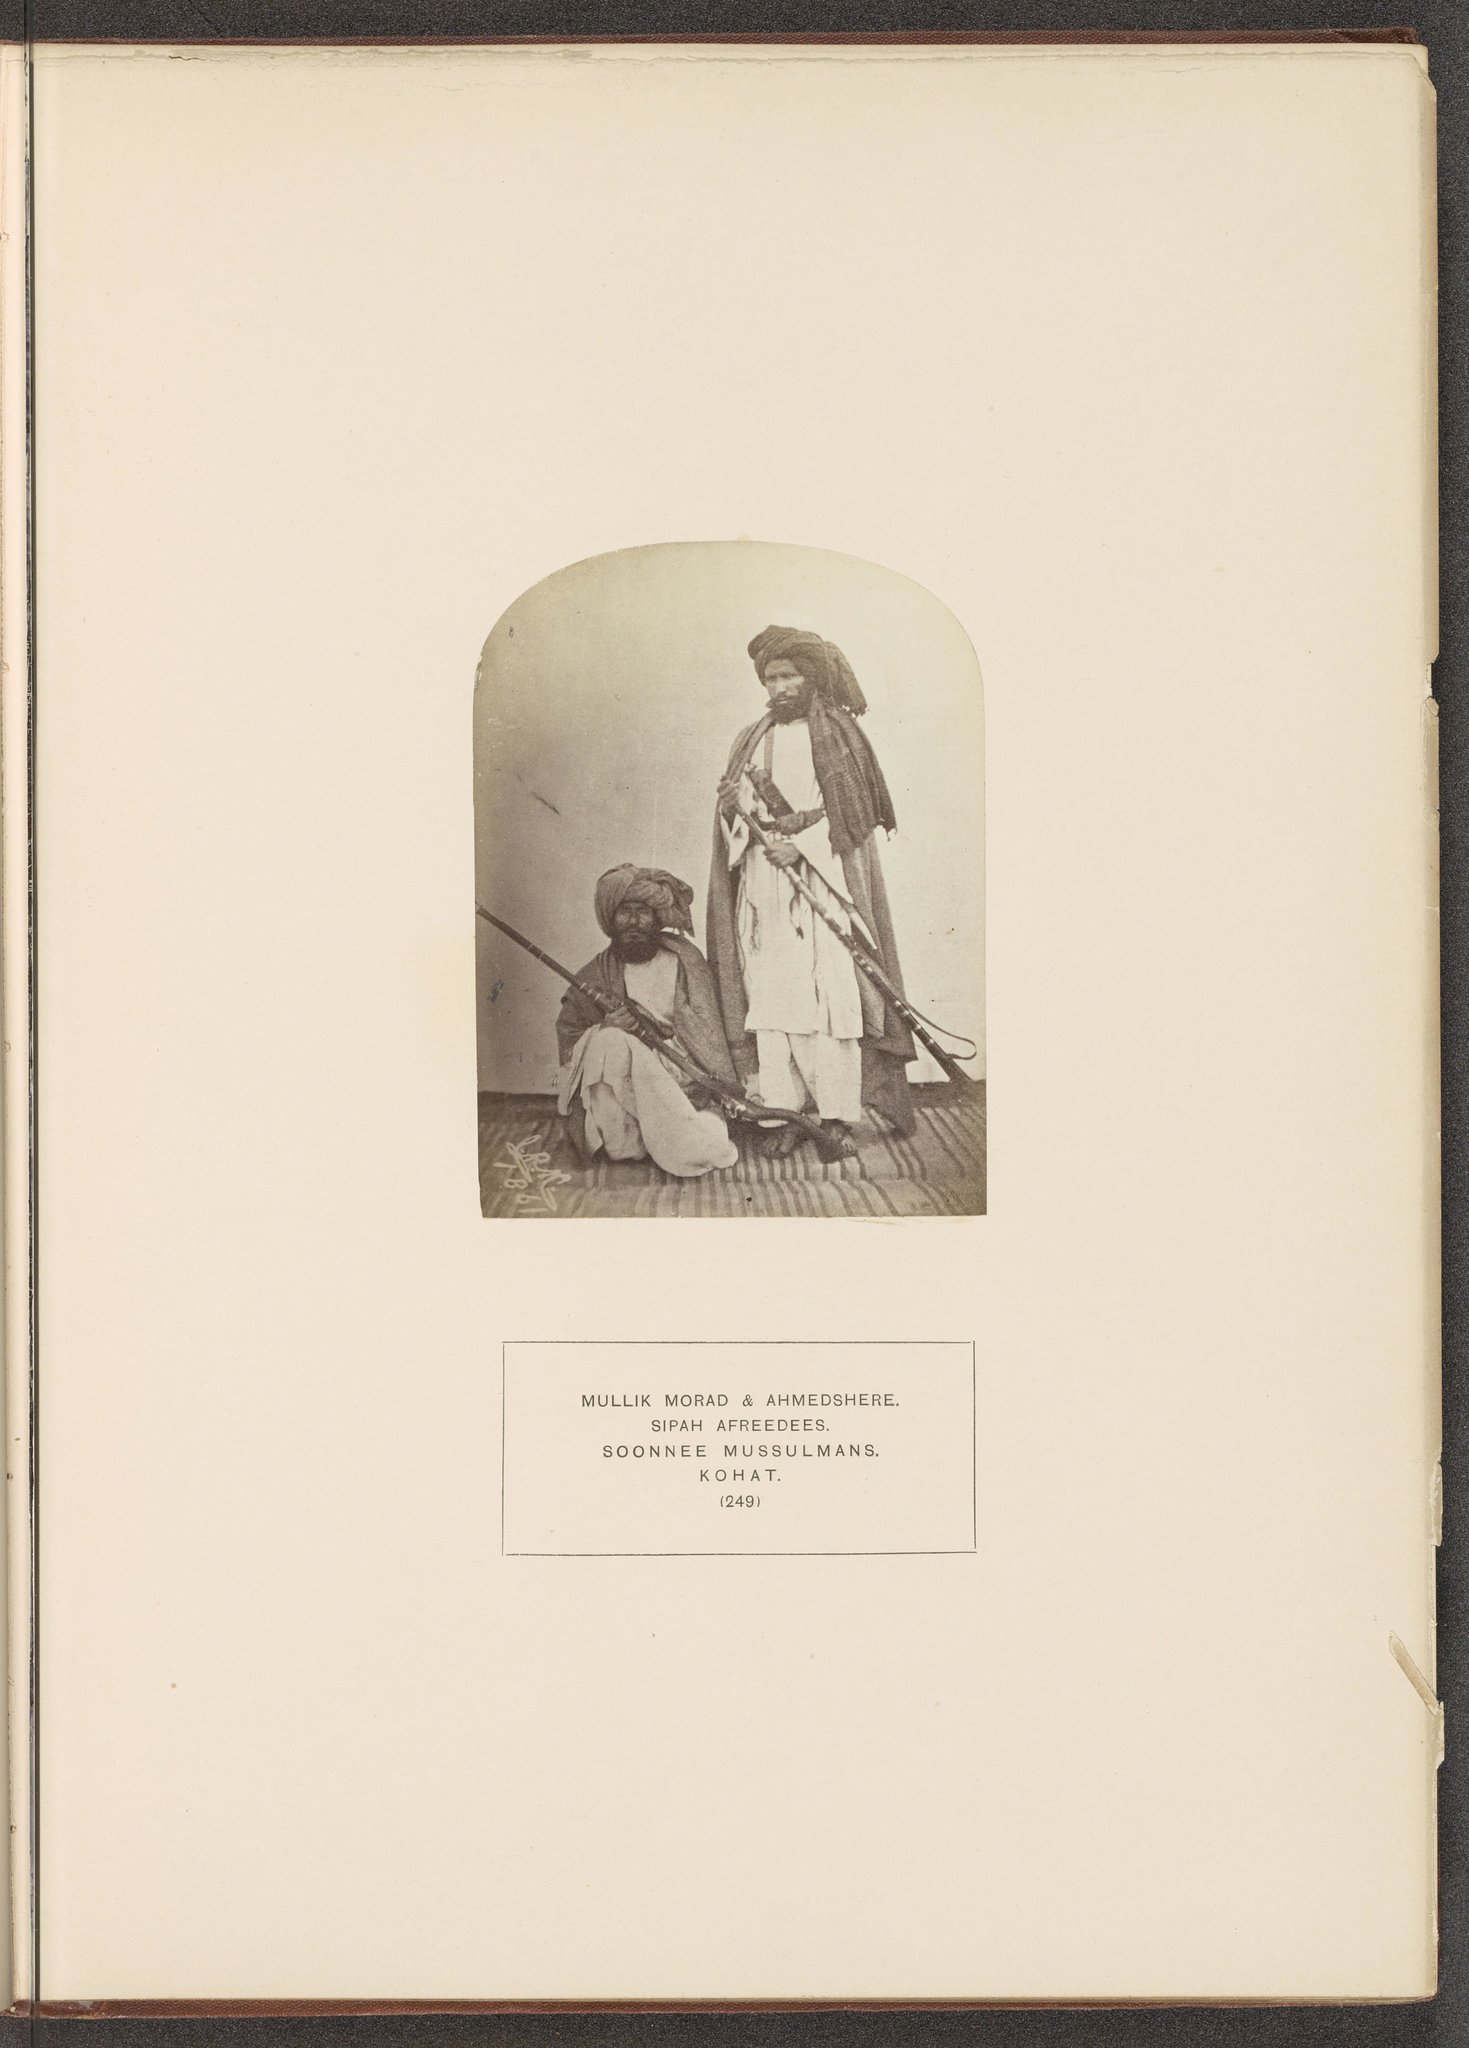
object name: page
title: Portrait of two men with muskets from the Sepah Afridi tribe of Kohat, Khyber Pakhtunkhwa, Pakistan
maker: Anonymous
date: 1861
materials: photographic support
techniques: albumen print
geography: kohat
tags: firearms: rifle, human races; peoples; nationalities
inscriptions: inscription, inscription: ‘MULLIK MORAD & AHMEDSHERE./ SIPAH AFREEDEES./ SOONNEE MUSSULMANS./ KOHAT.’, number: ‘(249)’